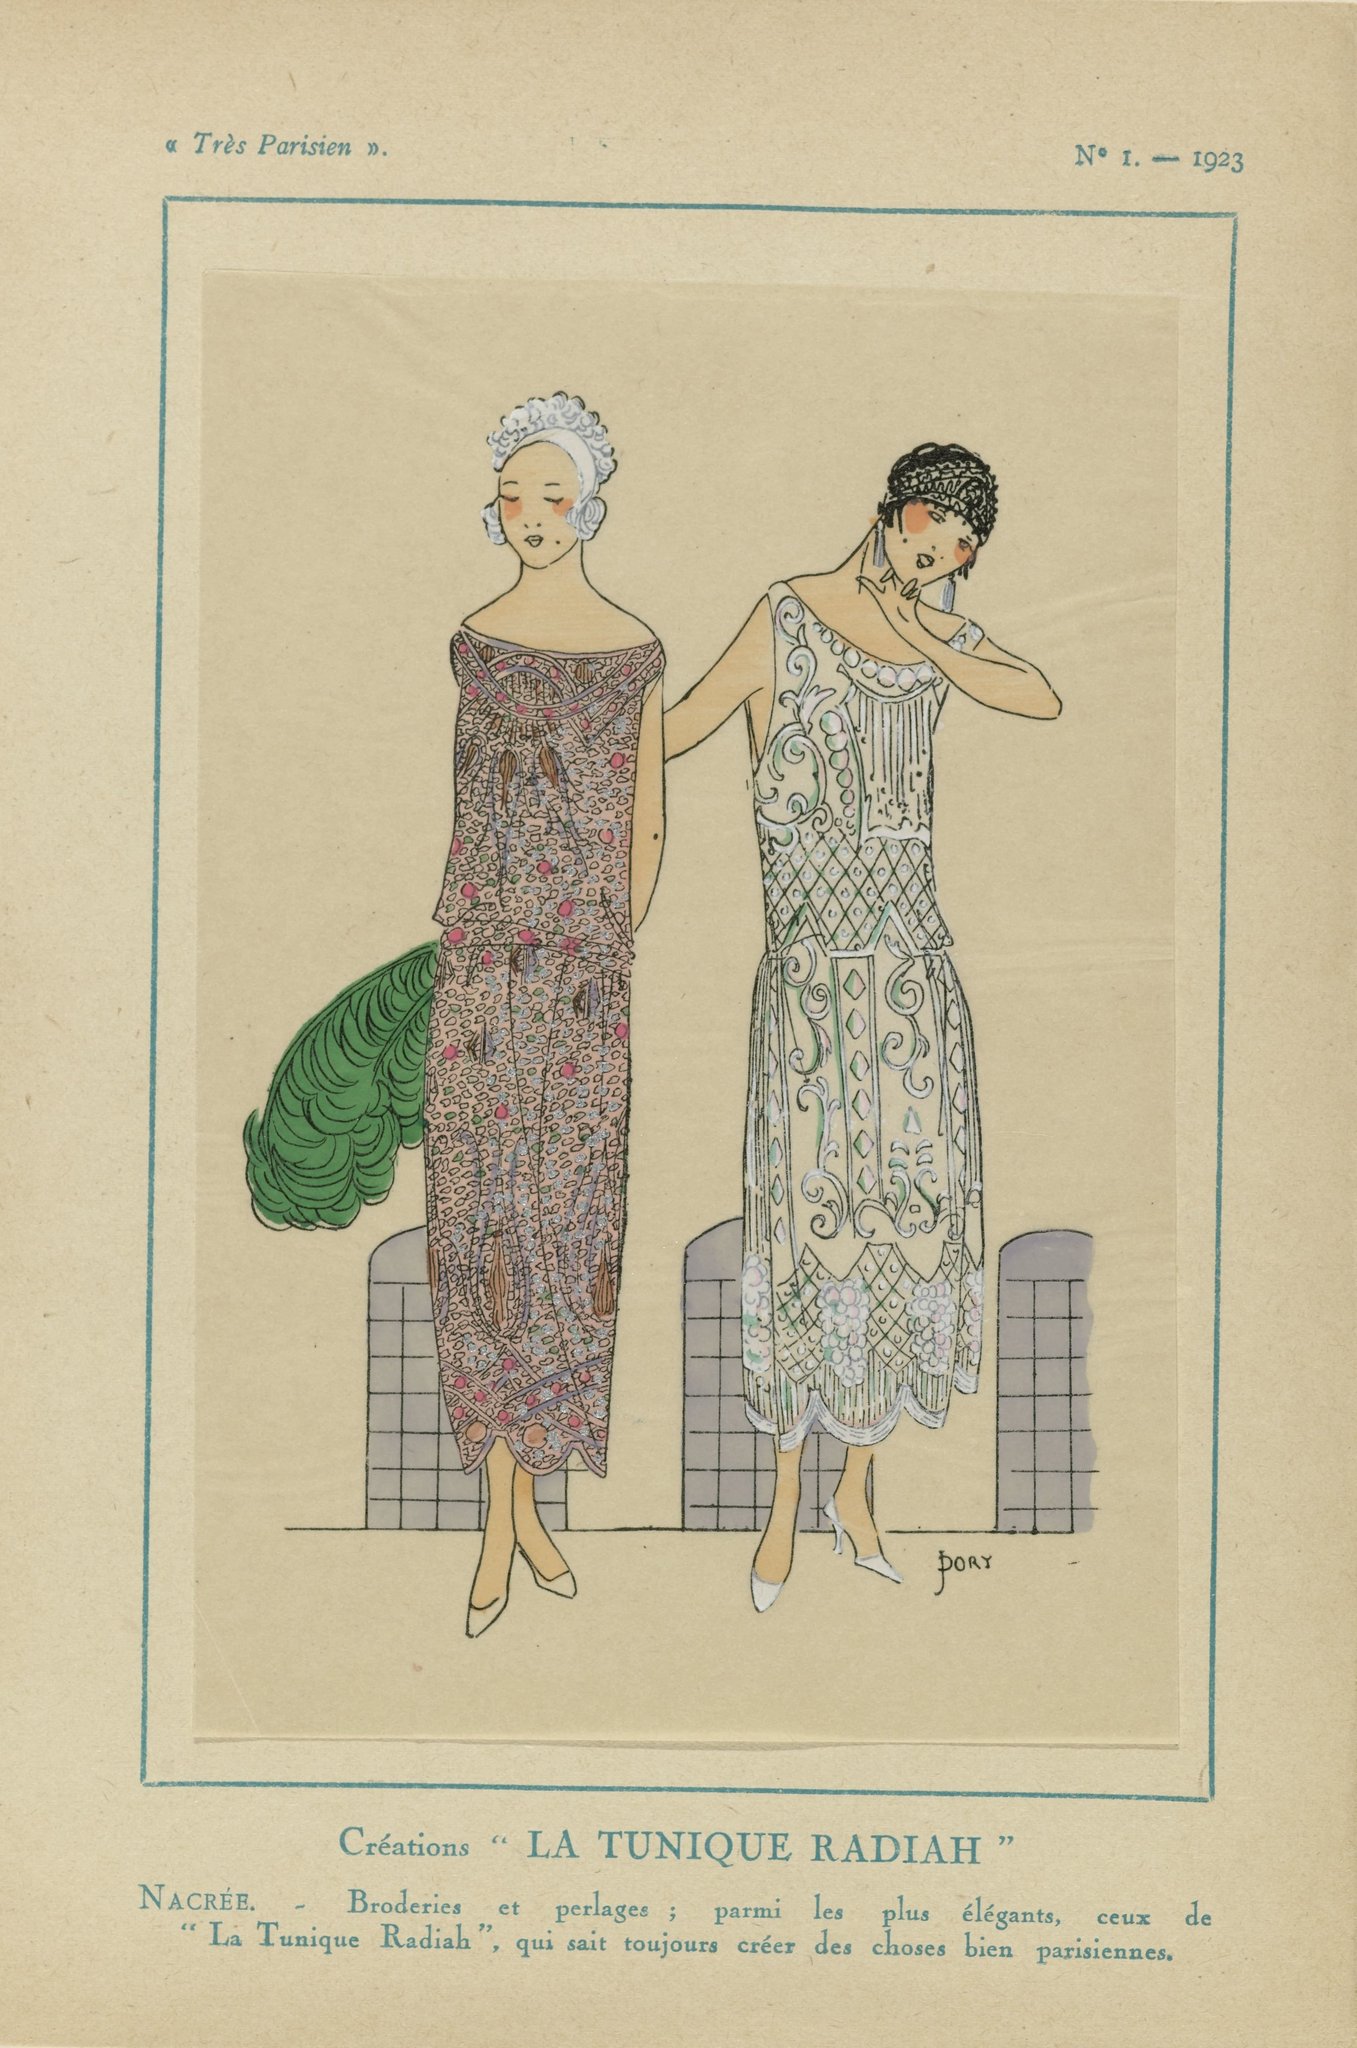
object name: fashion print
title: Très Parisien, 1923, No 1: Creations "LA TUNIQUE RADIAH"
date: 1923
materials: paper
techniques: hand coloring, letterpress printing, lithography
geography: paris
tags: diadem, tiara (+ women's clothes), dress, gown: evening dress (+ women's clothes), fashion plates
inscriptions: title: ‘Très Parisien / No 1. - 1923’, caption: ‘Créations "LA TUNIQUE RADIAH" / NACRÉE. - Broderies et perlages; parmi les plus élégants, ceux de "La Tunique Radiah", qui sait toujours créer des choses bien parisiennes.’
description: Twee avondjaponnen van 'La Tunique Radiah', gegarneerd met borduursel en parels. Prent uit het modetijdschrift Très Parisien (1920-1936).